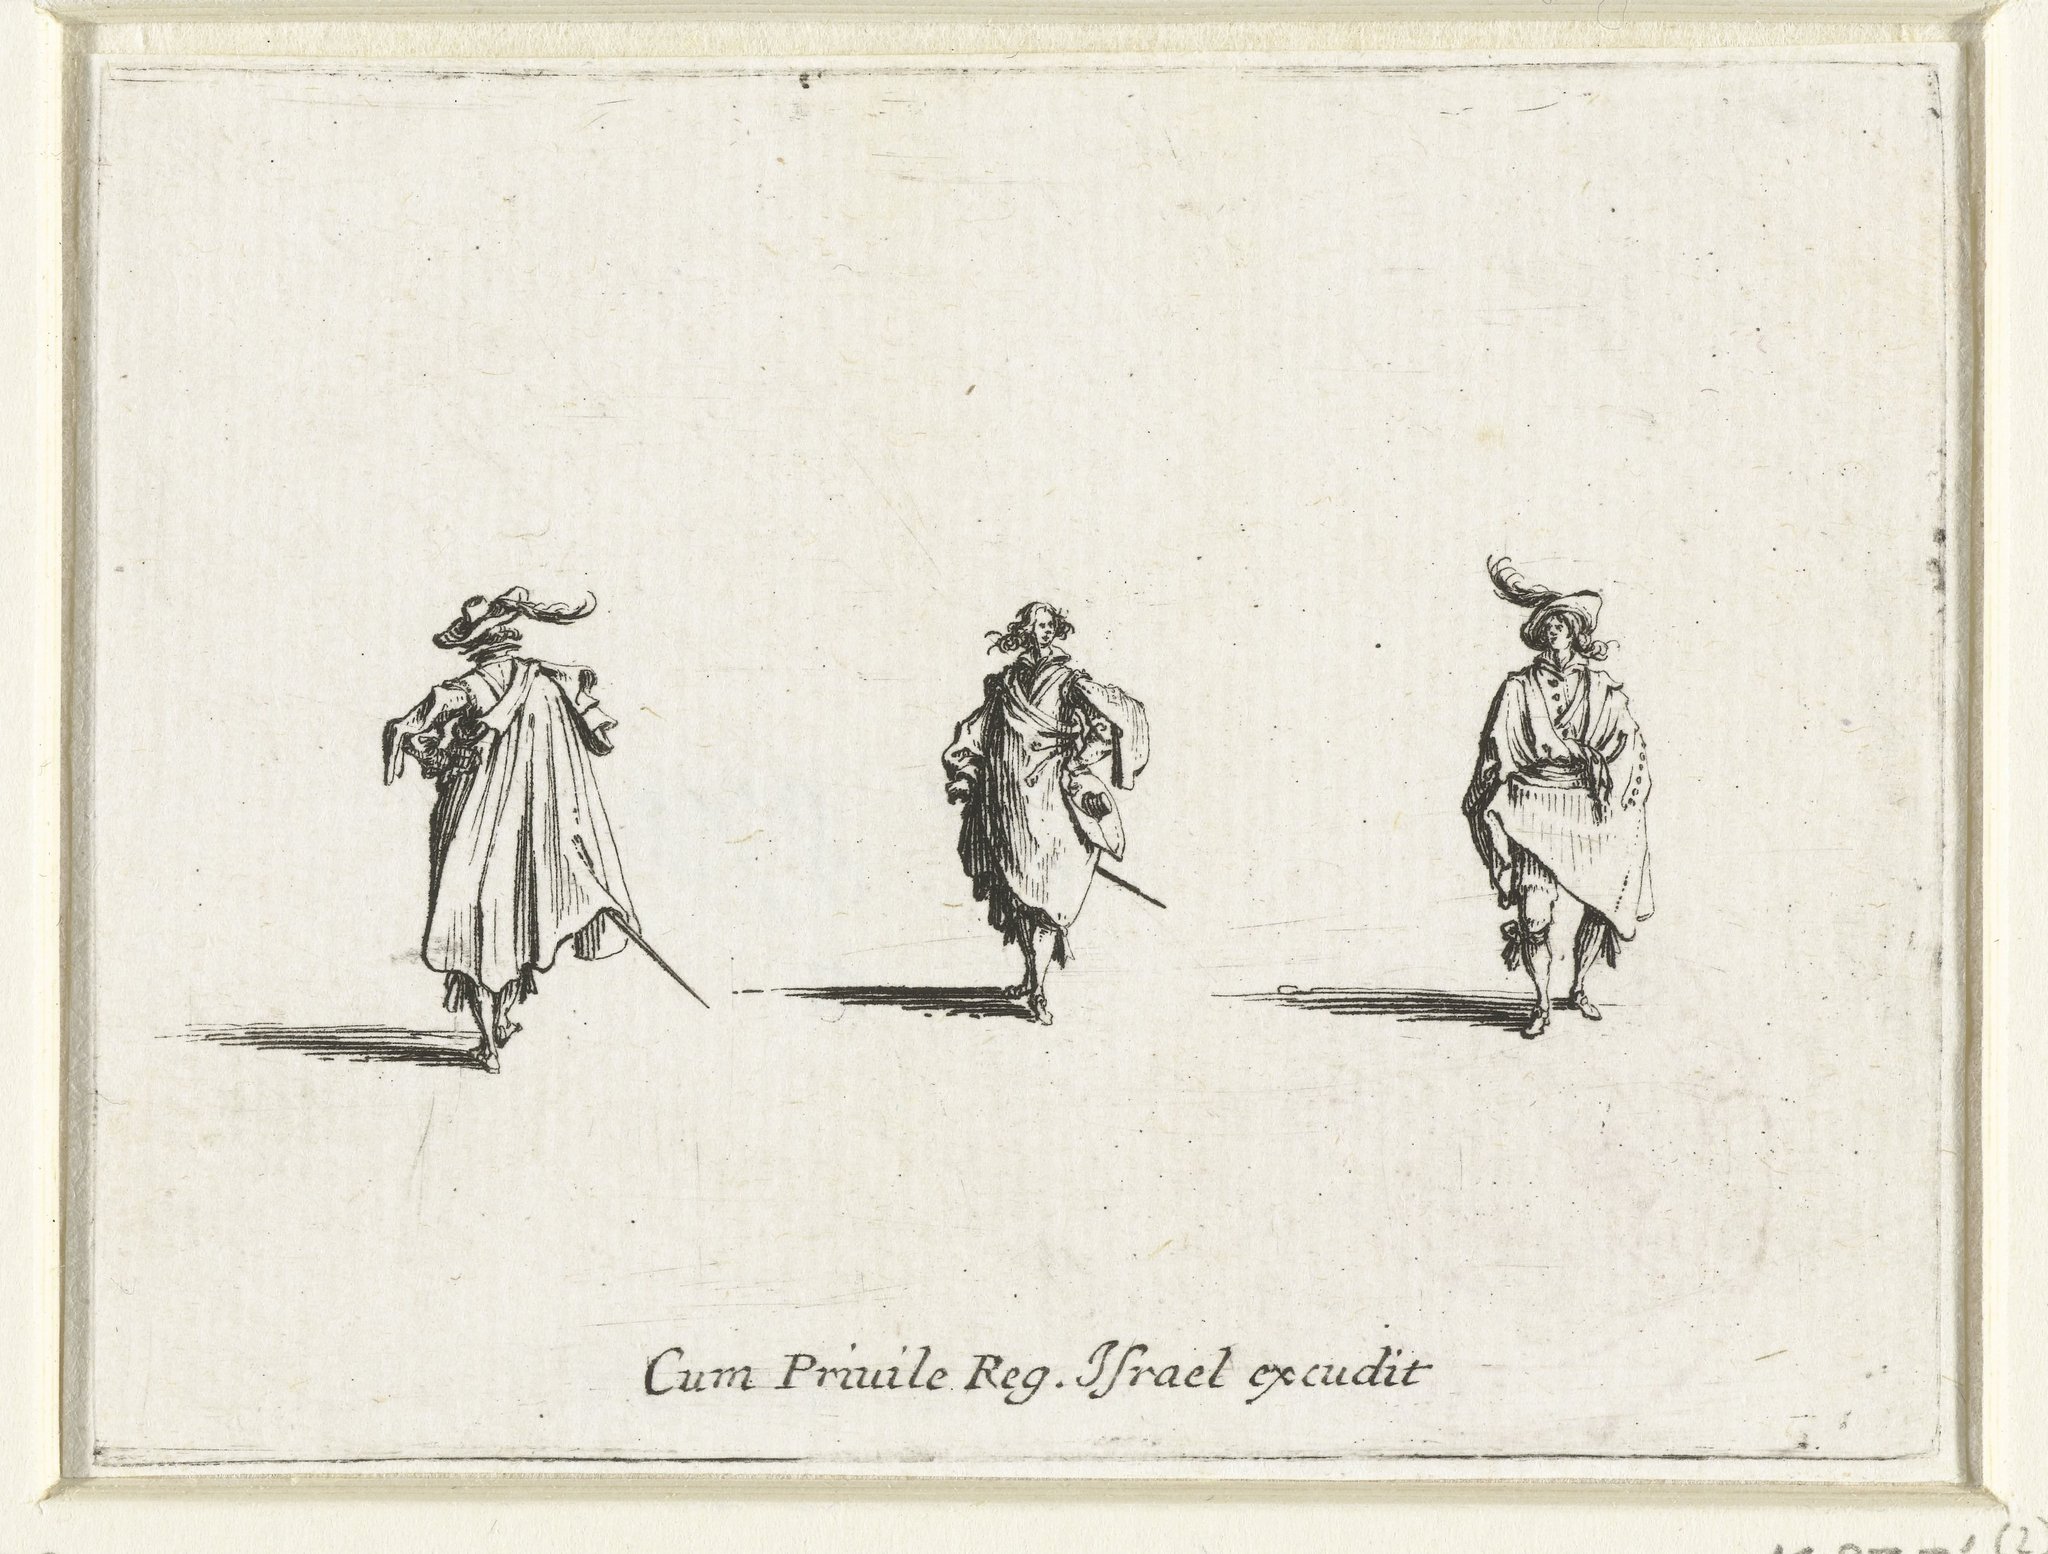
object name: costume print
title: Dertien trio's: dames en heren uit de tijd van Lodewijk XIII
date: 1633-1635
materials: paper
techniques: etching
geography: nancy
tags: clothes, costume (+ men's clothes), france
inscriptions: collector's mark: Lugt 240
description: Links een heer, een mantel over de rechterschouder, op de rug gezien. In het midden een heer, de linkerhand in de zij, van voren gezien. Rechts een heer, in een mantel gehuld, van voren gezien. Deze prent is onderdeel van een serie van 13 prenten (14 incl. titelprent) met telkens drie figuren naast elkaar. Op elf prenten staan twee heren om één dame, op één prent staan drie heren en op één prent staan drie vrouwen. Mogelijk zijn deze prenten bedoeld geweest als tekenvoorbeelden.